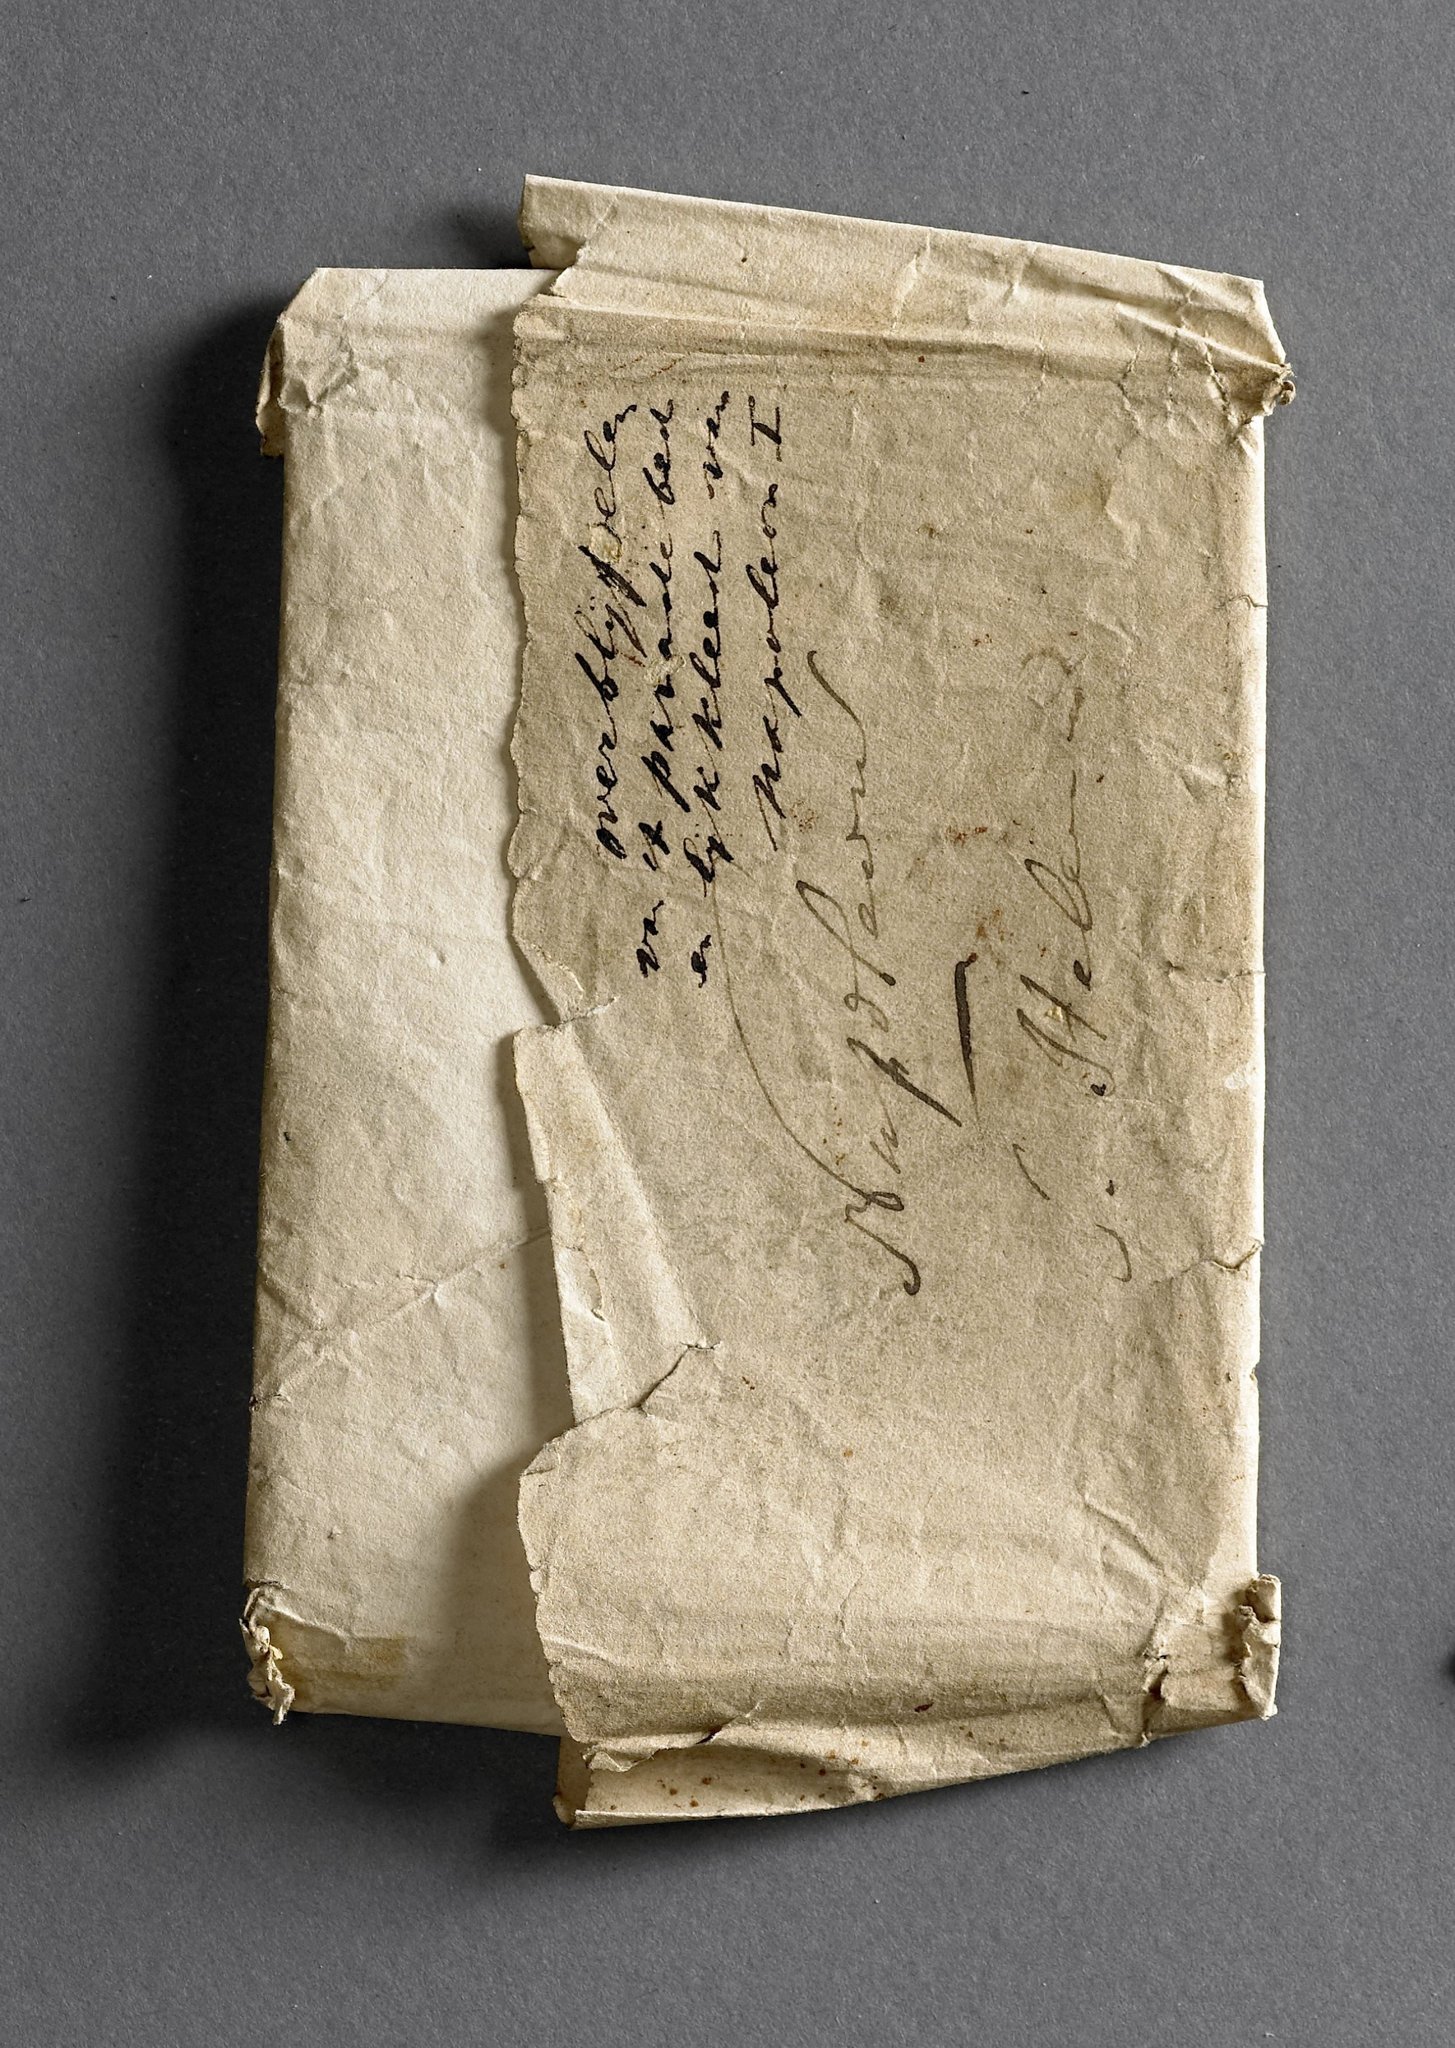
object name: fragment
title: Papier met handschrift waarin overblijfselen van het paradebed en lijkkleed van Napoleon I worden bewaard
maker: Anonymous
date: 1821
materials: paper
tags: the hague, sculptor, theo simons, napoleon i (emperor of the french), bed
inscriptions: inscription: ‘Overblijfselen van het paradebed en lijkkleed van Napoleon I. Napoleon, S. Helena’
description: Papier met handschrift waarin overblijfselen van het paradebed en lijkkleed van Napoleon I worden bewaard. Op het stukje wit papier staat geschreven in zwarte inkt: Overblijfselen van het paradebed en lijkkleed van Napoleon I. Napoleon, S. Helena.